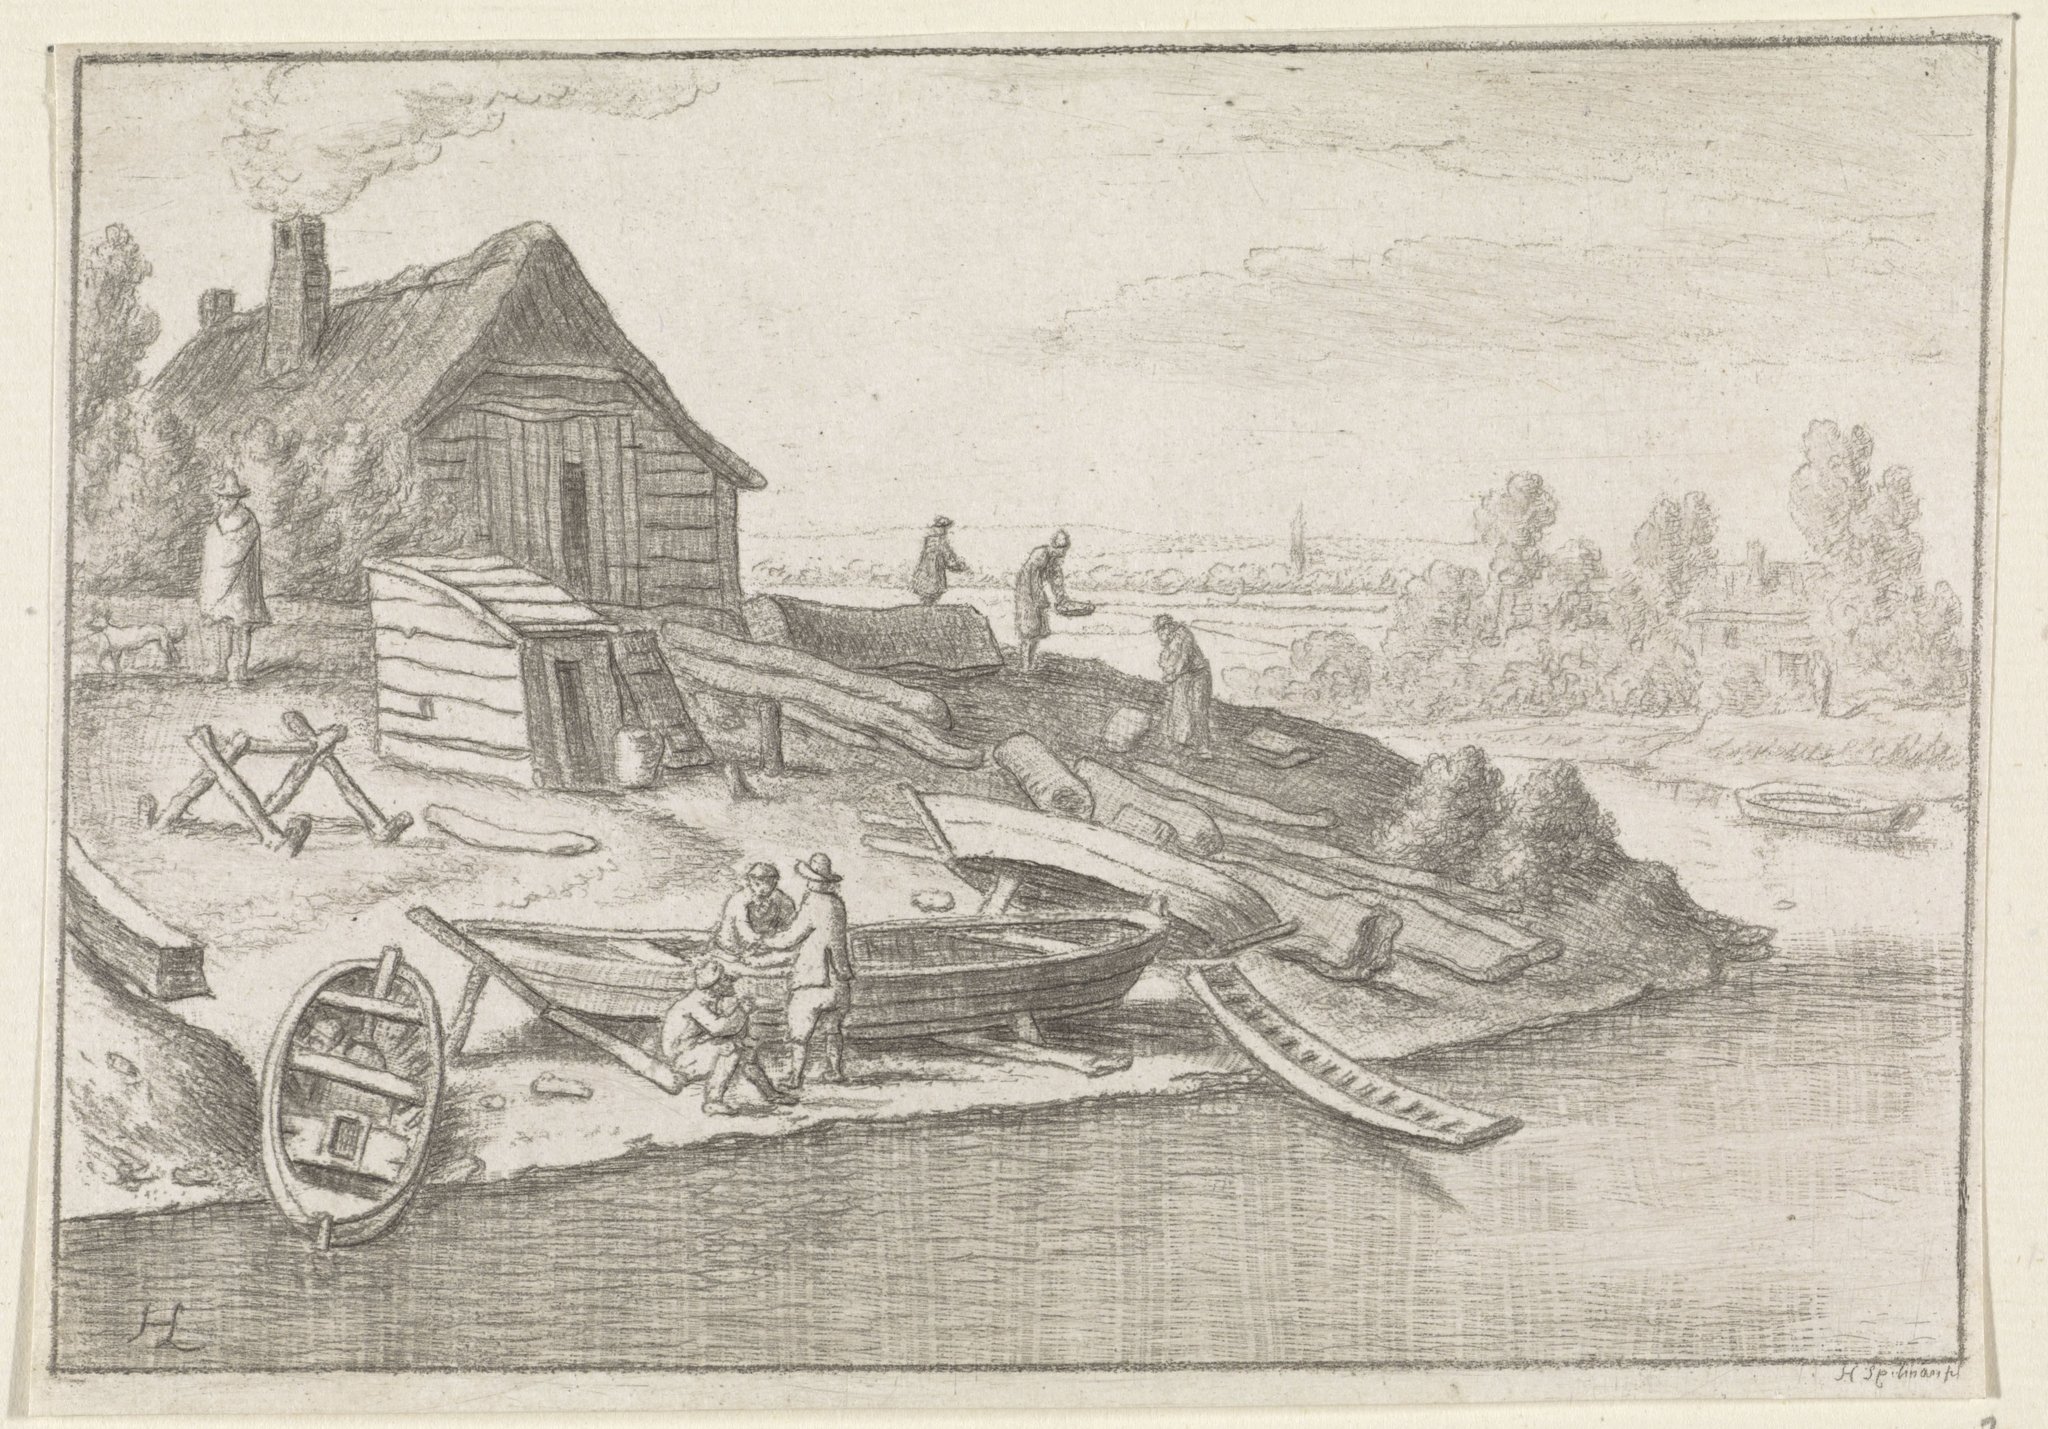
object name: print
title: Gezicht op een scheepstimmerwerf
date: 1742-1784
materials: paper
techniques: etching, roulette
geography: haarlem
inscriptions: collector's mark: Lugt 2760, collector's mark: Lugt 2228